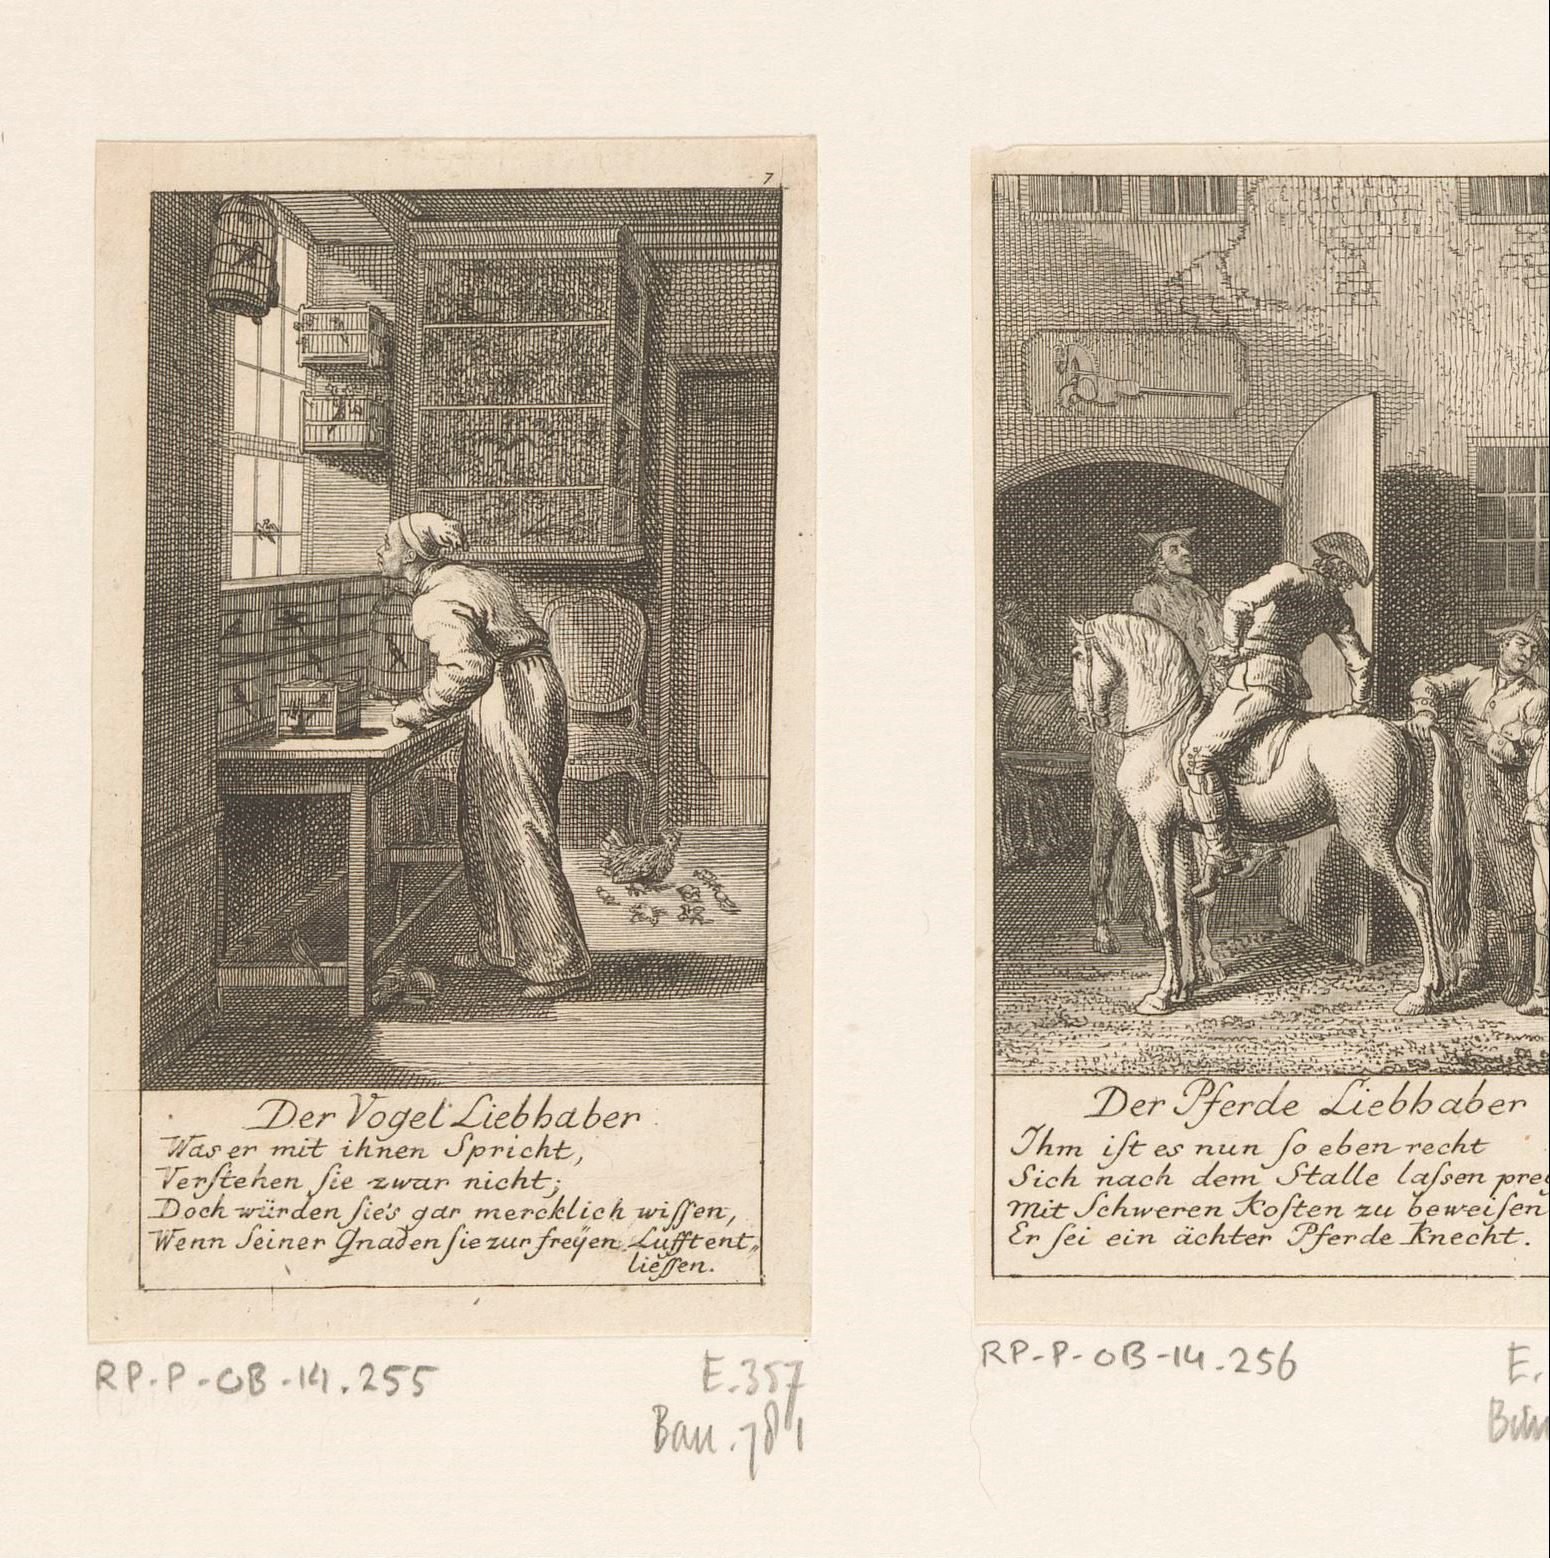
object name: print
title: Vogelliefhebber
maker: daniel nikolaus chodowiecki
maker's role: draughtsman, print maker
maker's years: 1726-1801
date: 1780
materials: paper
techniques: etching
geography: berlin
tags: birds in a large cage, aviary, collecting (leisure time activity), birds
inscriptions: collector's mark: Lugt 2228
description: Prent gebruikt voor: Königl. Grossbr. Genealogischer Kalender auf das Jahr 1781. Lauenburg: J.G. Berenberg, [1780].